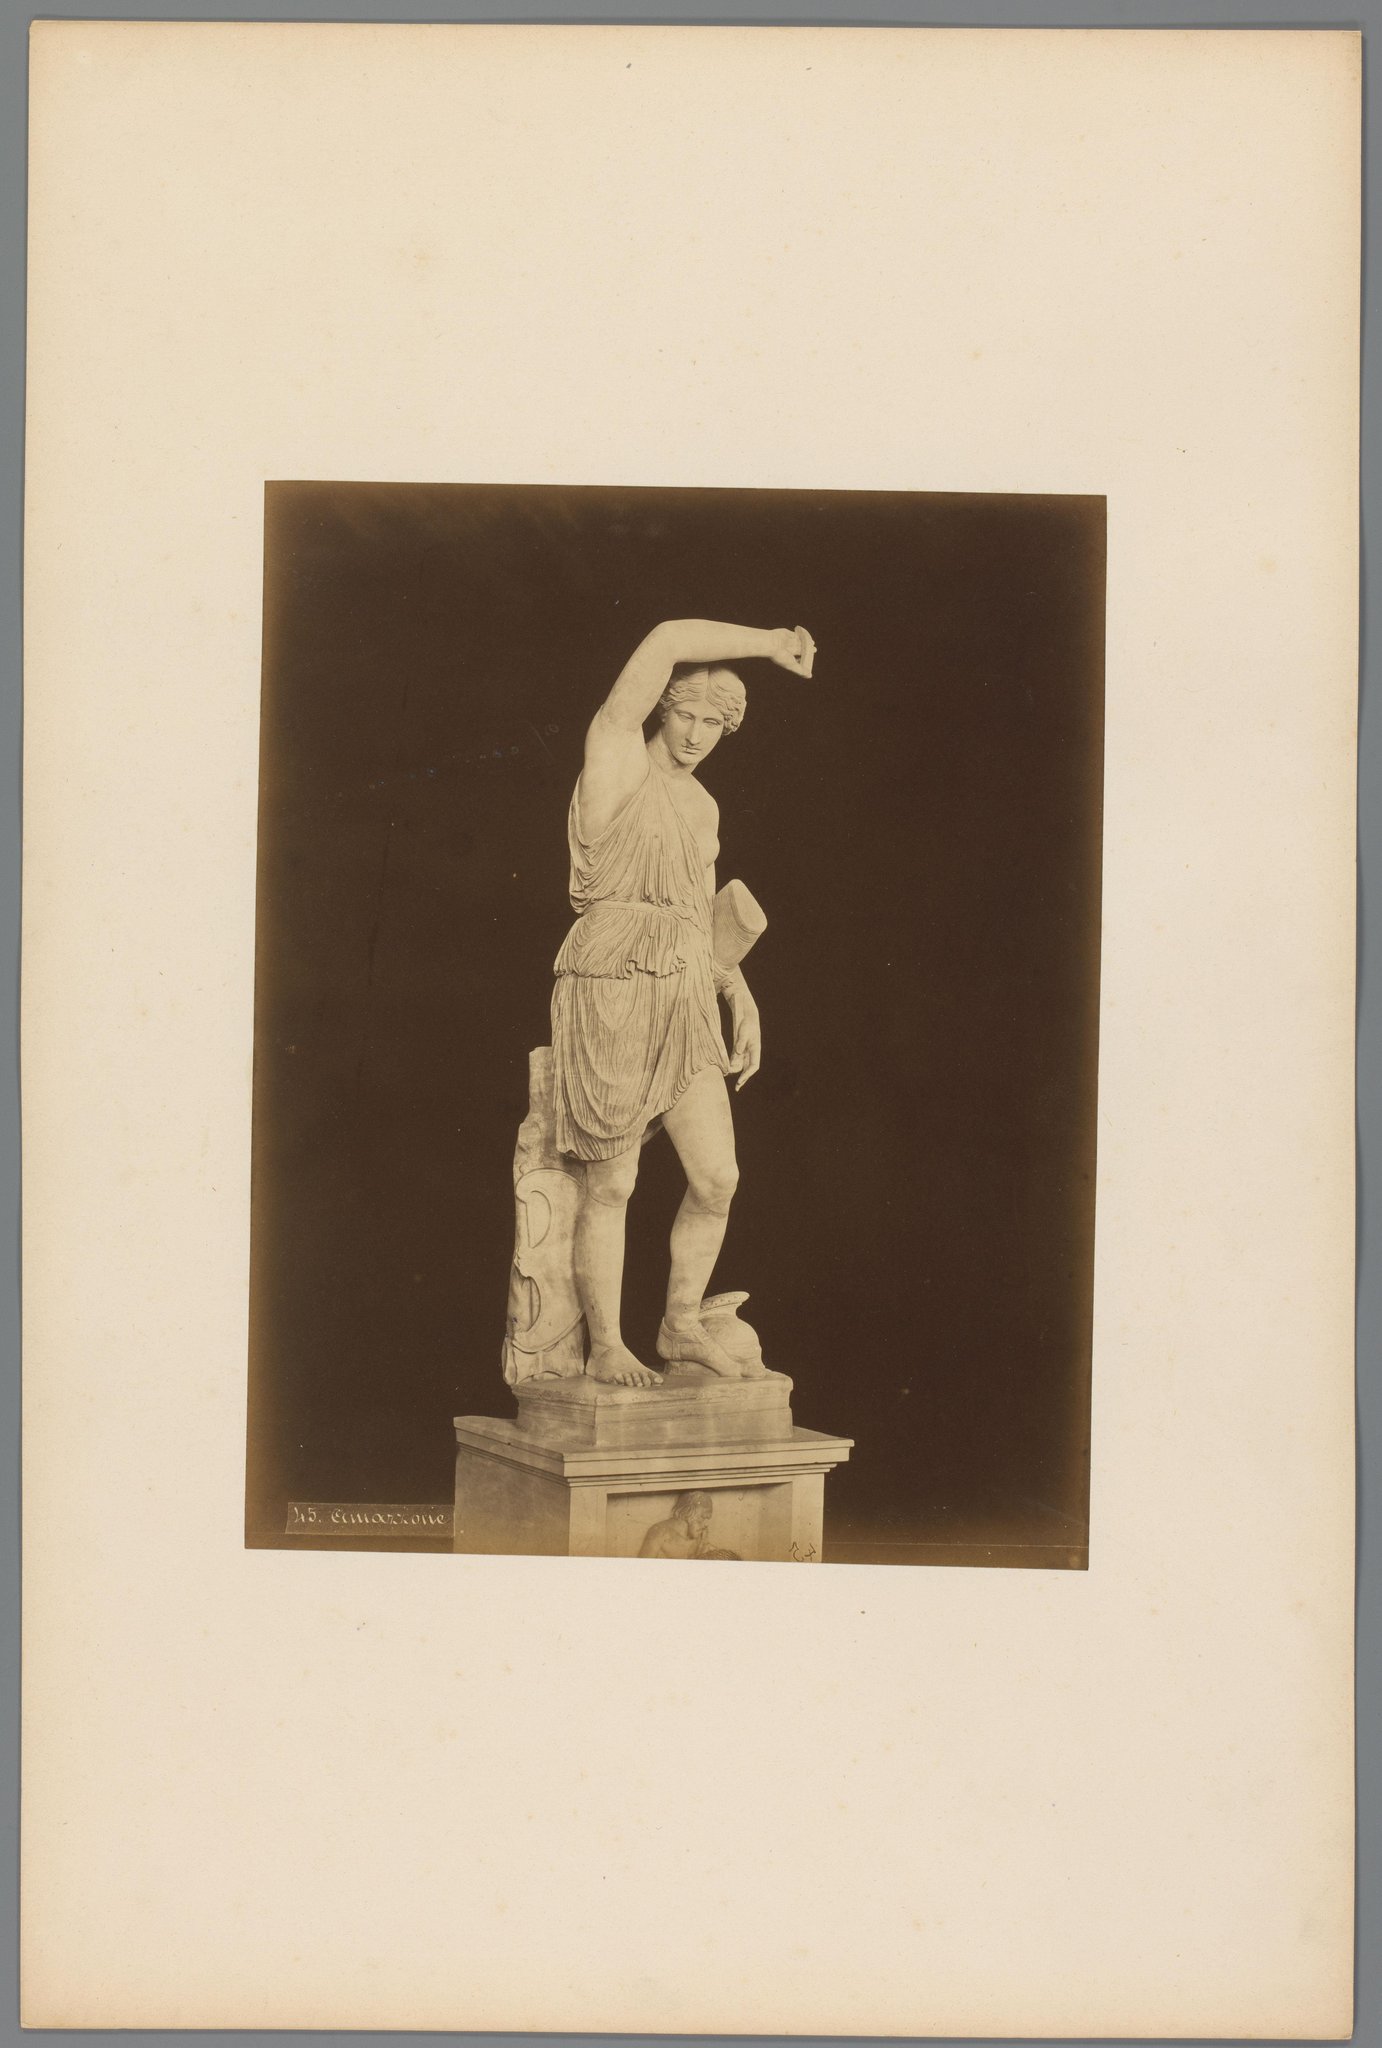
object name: photograph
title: Amazzone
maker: Anonymous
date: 1851-1900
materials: cardboard, paper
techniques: albumen print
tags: (story of) the amazons, piece of sculpture, reproduction of a piece of sculpture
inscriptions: number: ‘45.’